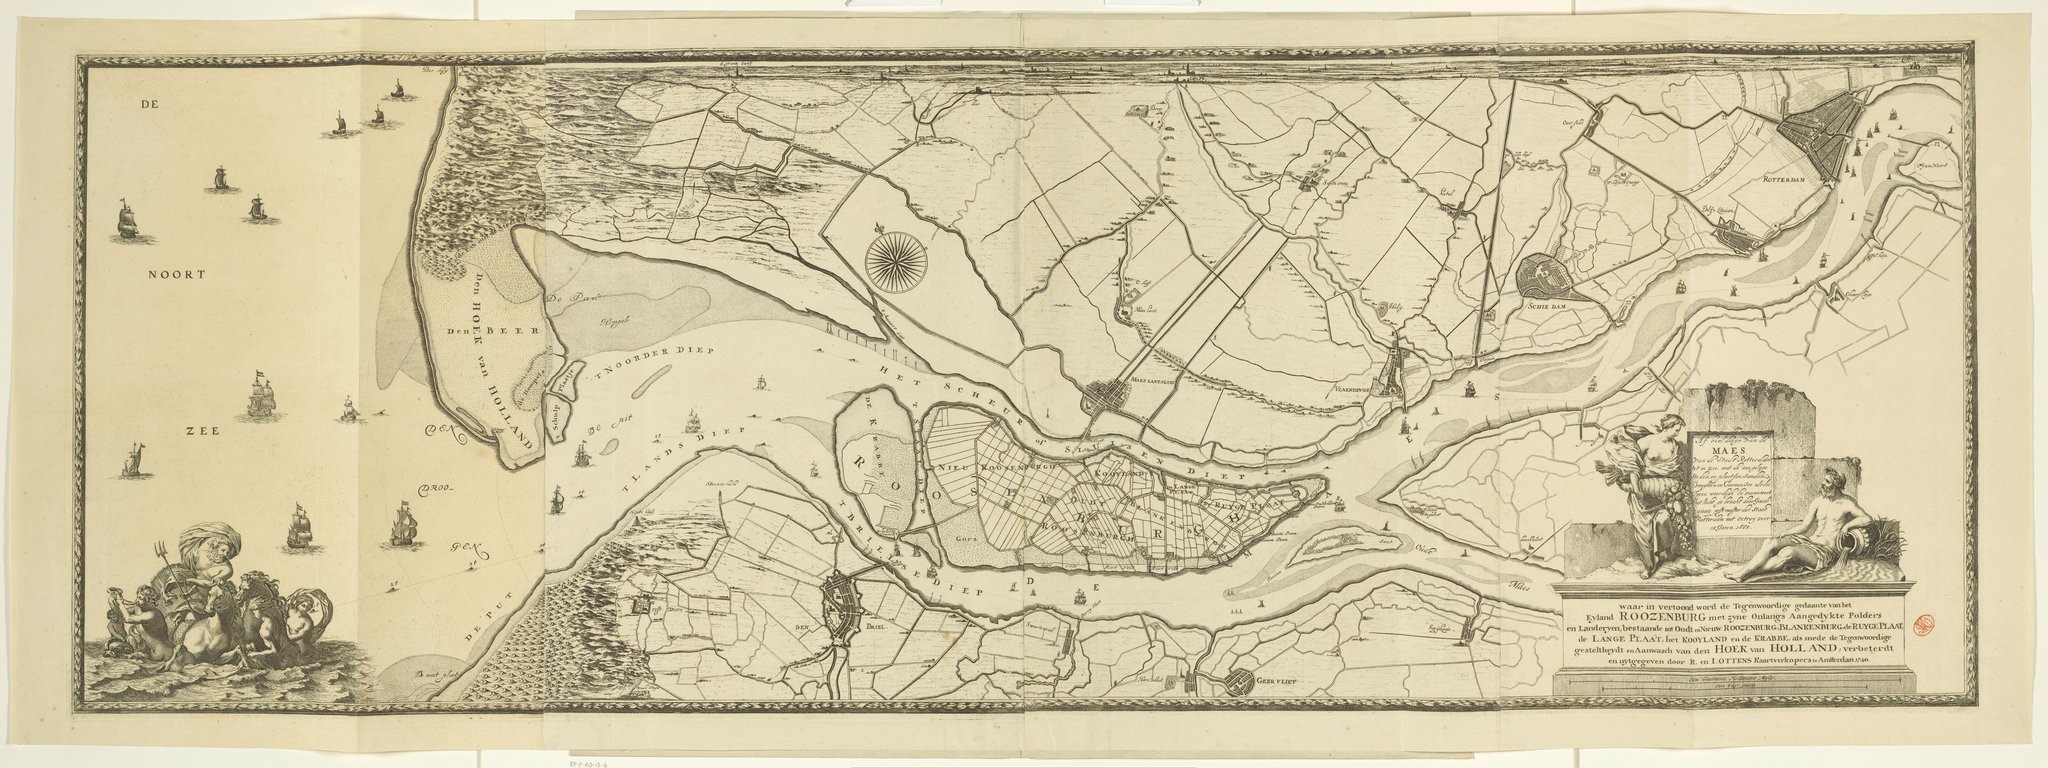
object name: print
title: Kaart van de Maas van Rotterdam tot de Noordzee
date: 1666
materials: paper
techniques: engraving, etching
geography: rotterdam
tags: 'cornucopia', horn of plenty, triton(s), maps of separate countries or regions, river-gods, maps of cities, neptune as lord of the sea, delfshaven, geervliet, rotterdam, brielle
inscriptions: collector's mark: Lugt 195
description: De eerste staat van deze prent is oorspronkelijk bedoeld als onderdeel van de zogenaamde Maaskaart uit 1666, verschenen onder de titel 'Rotterodamum Hollandiae urbs celeberrima et situ portibusque mercaturae opportunissima. Ao. 1665'. Hoewel het jaartal 1665 in de titel stond, blijkt uit archiefonderzoek dat de kaart pas in 1666 gereed was (zie documentatie). Zie ook RP-P-AO-13-5 voor meer informatie.